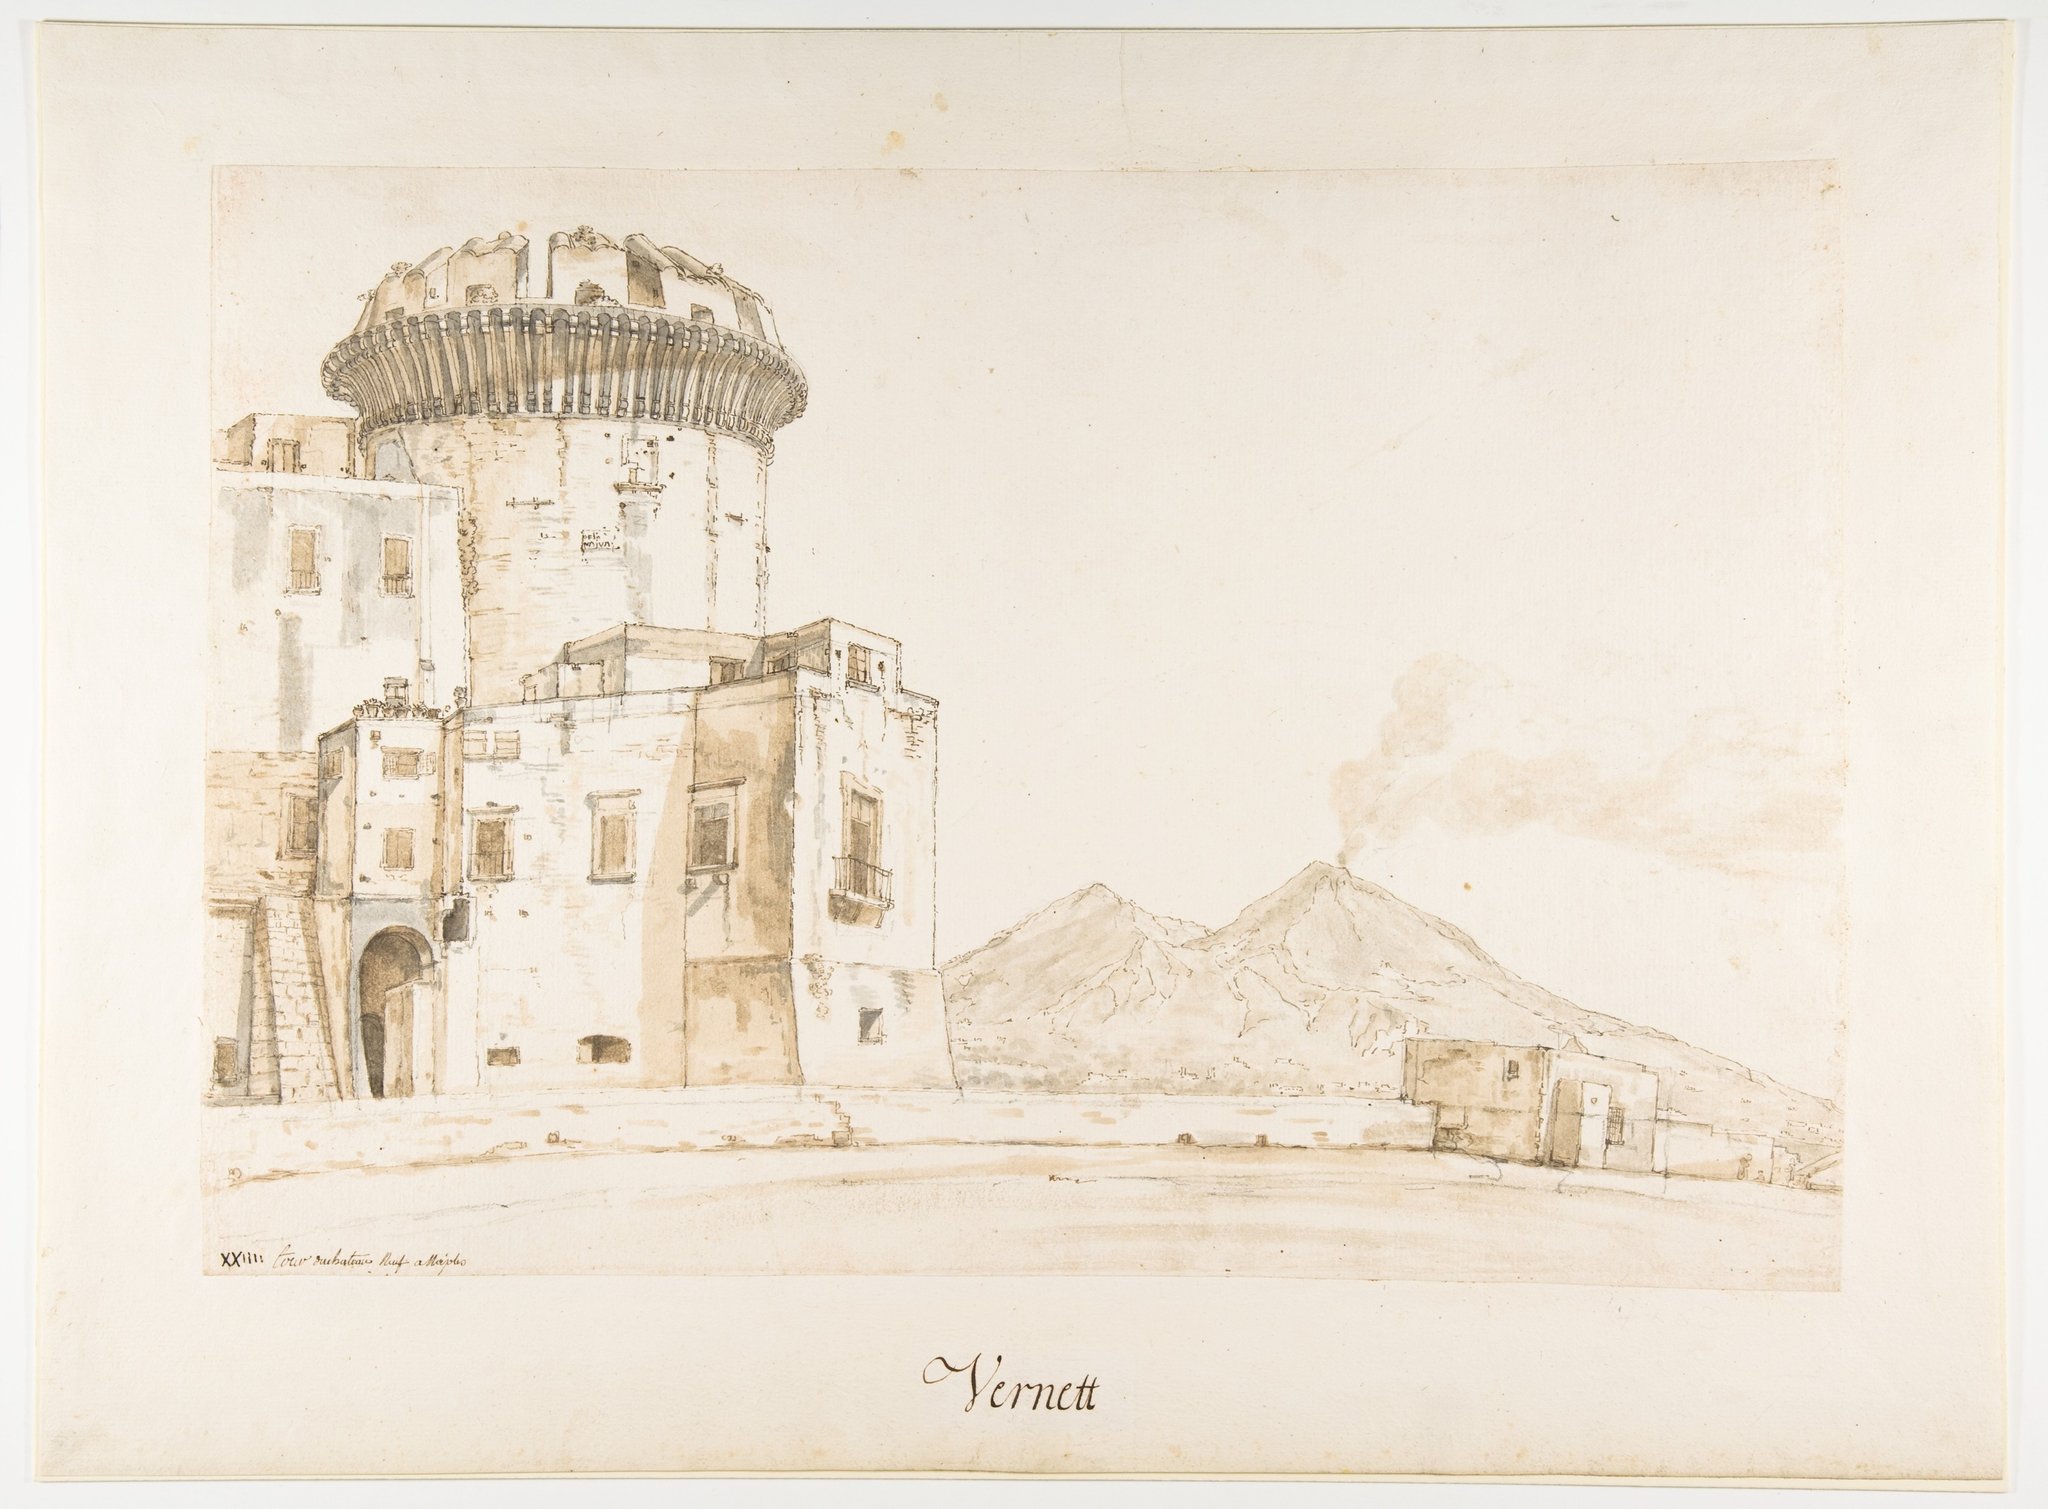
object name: drawing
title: The Castel Nuovo in Naples, with a View of Mount Vesuvius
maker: joseph vernet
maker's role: artist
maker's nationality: french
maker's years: 1714-1789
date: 1737-1753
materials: chalk, ink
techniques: brush, pen, wash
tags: castles,mountains